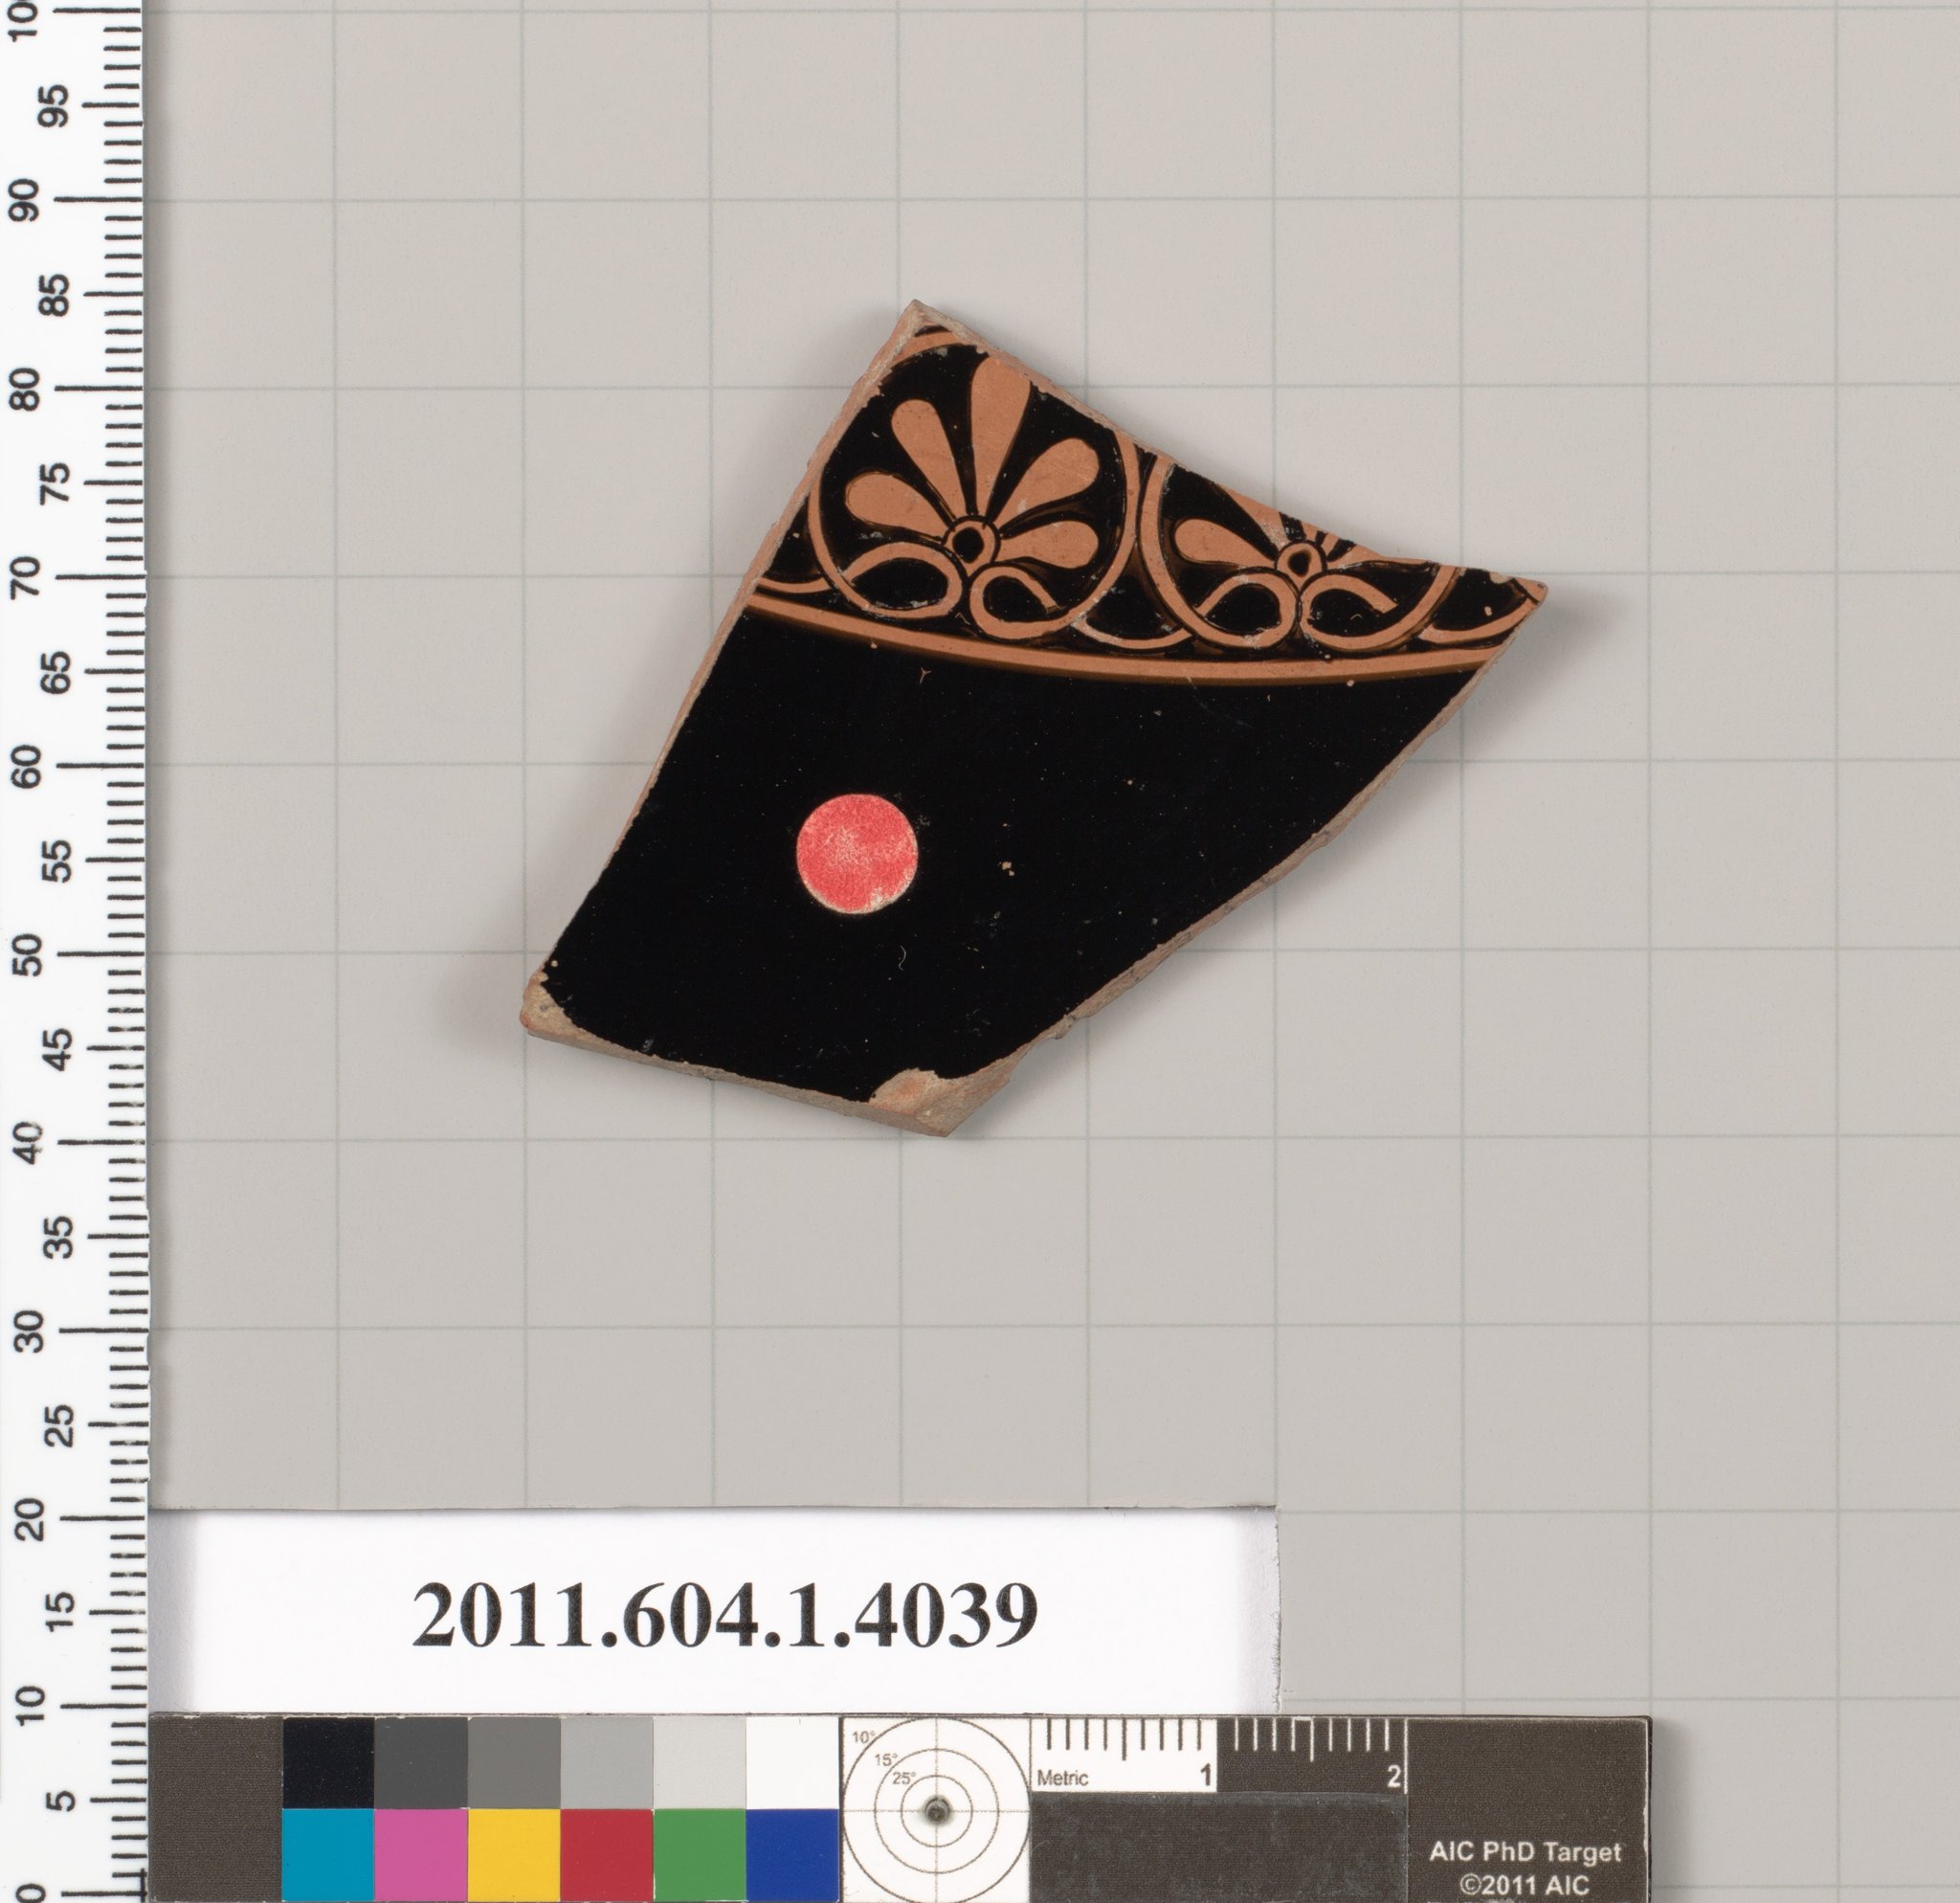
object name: kylix fragment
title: Terracotta fragment of a kylix (drinking cup)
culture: greek, attic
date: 534-468 BCE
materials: terracotta